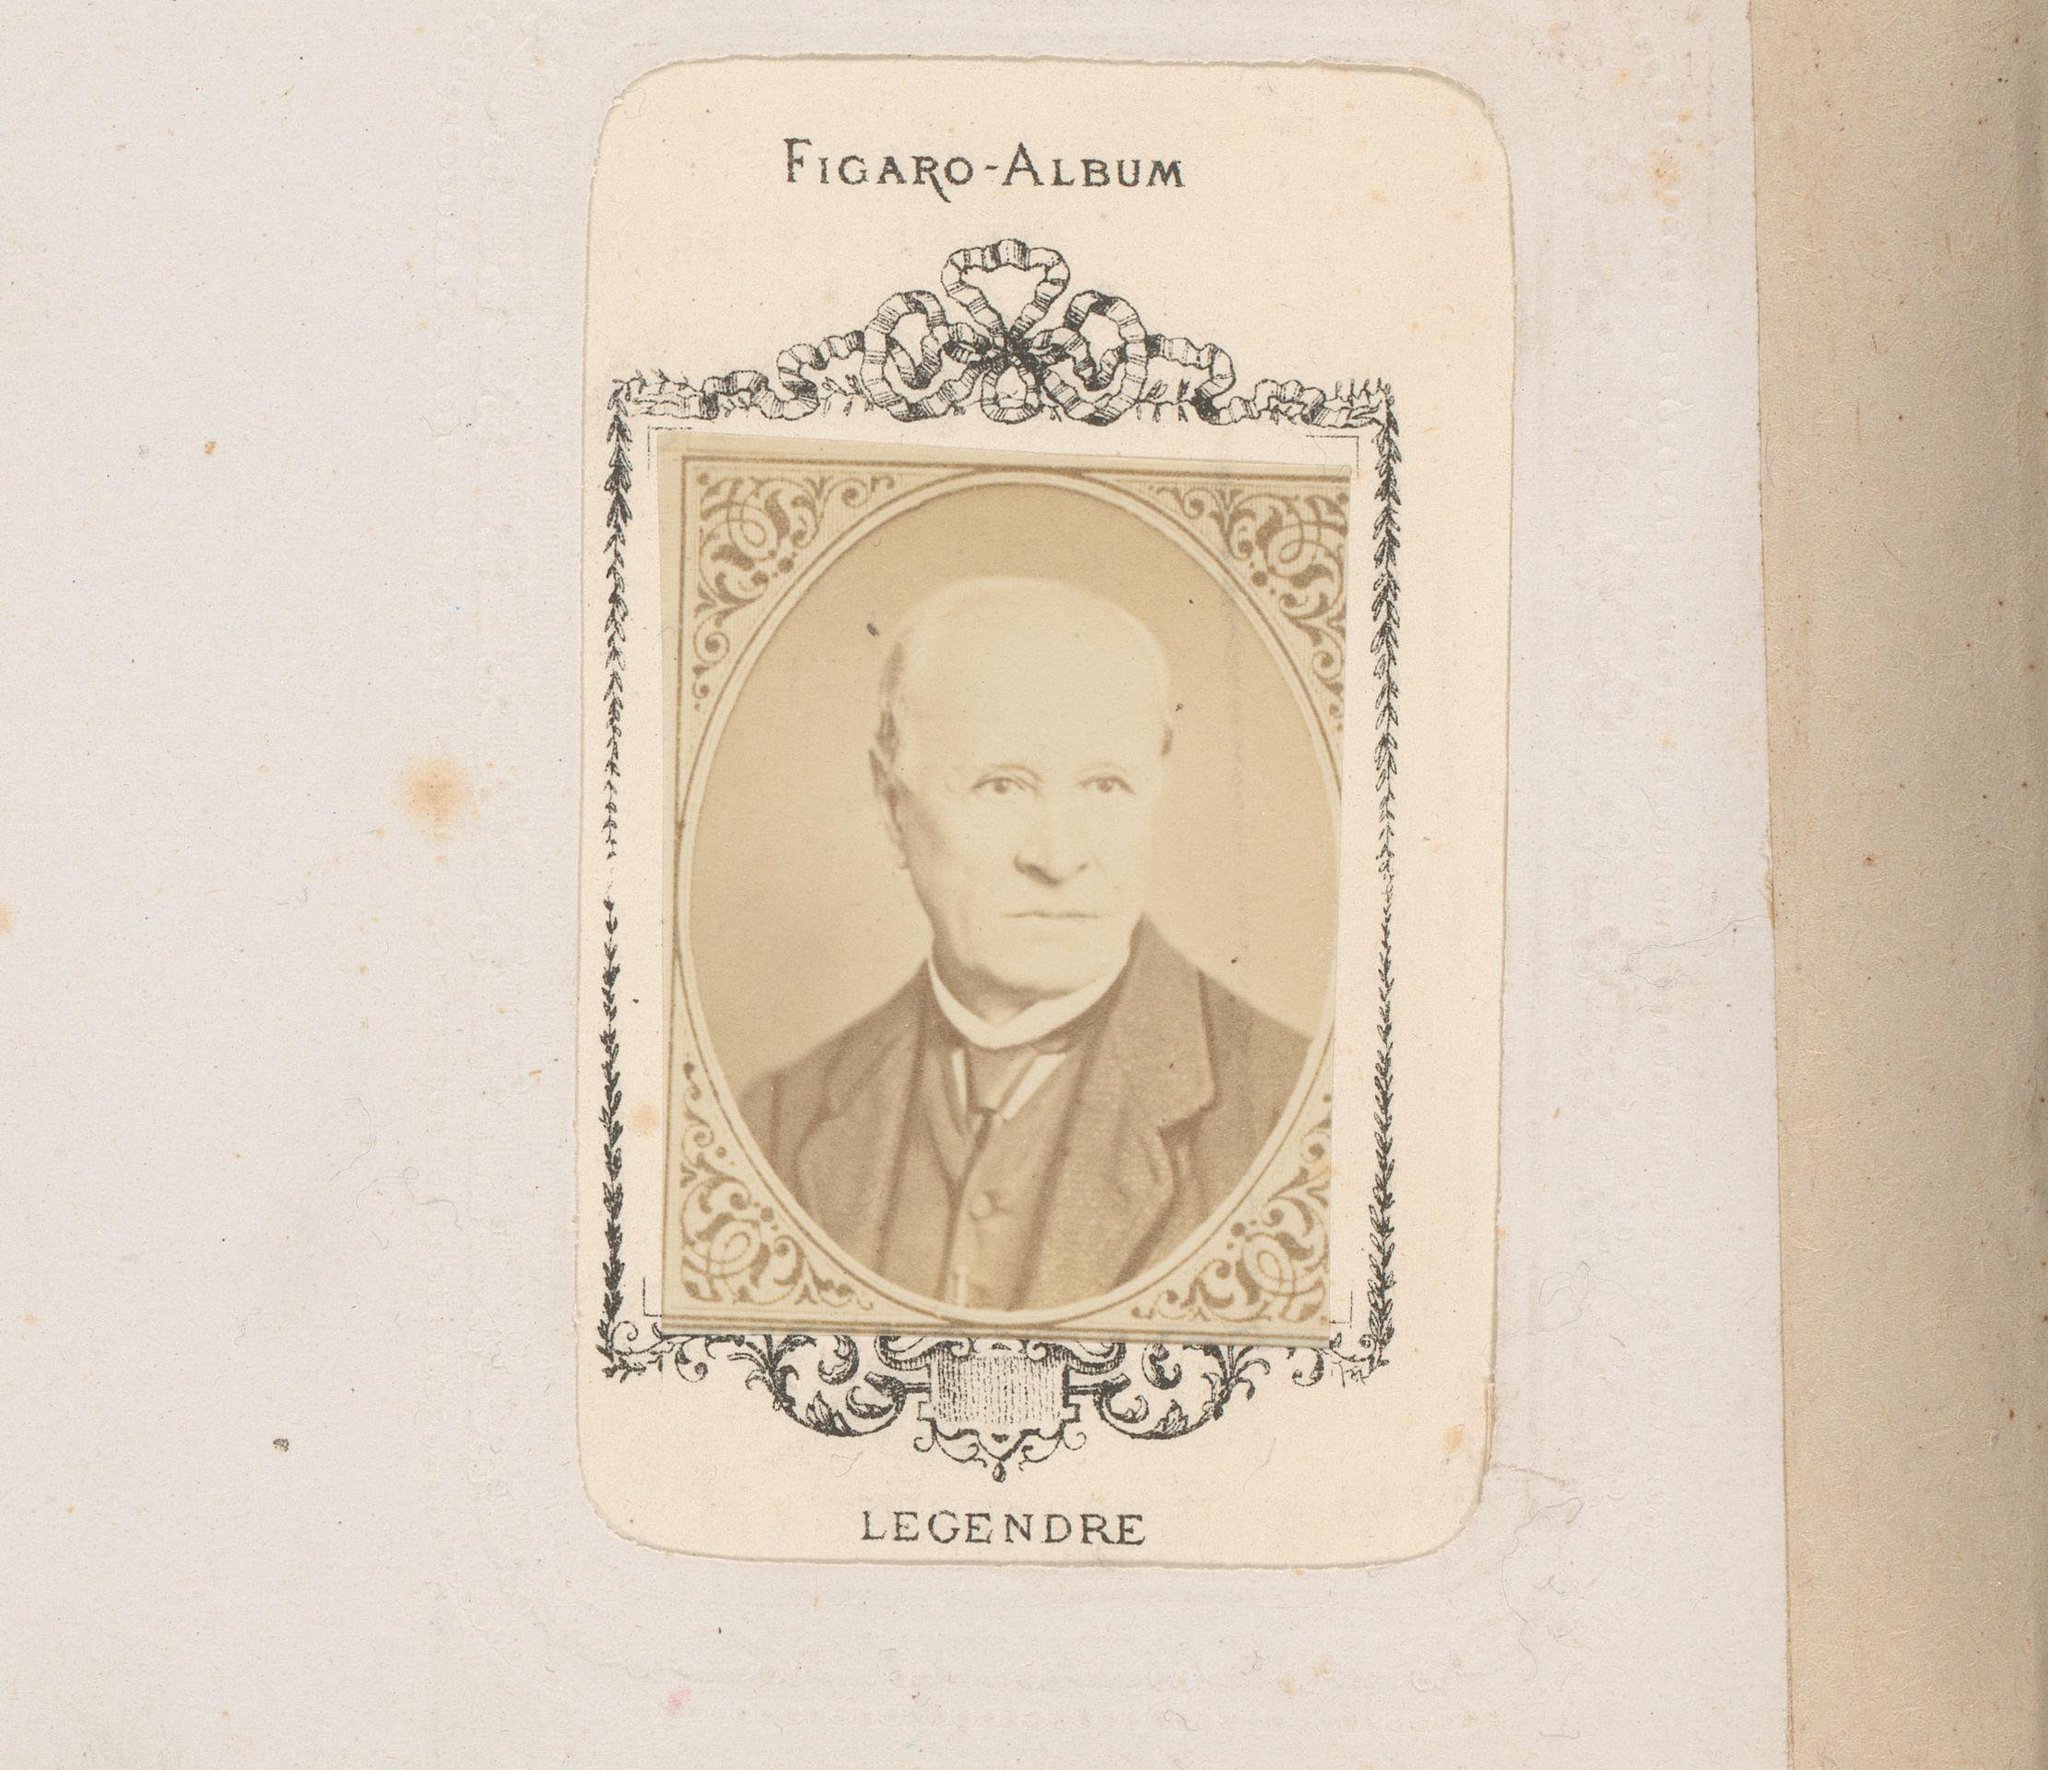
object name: photograph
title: Fotoreproductie van een portret van een man, aangeduid als Legendre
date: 1860-1900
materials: cardboard, photographic support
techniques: albumen print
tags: historical persons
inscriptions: inscription: ‘Figaro-Album/ Legendre/ Liébert Phot.’